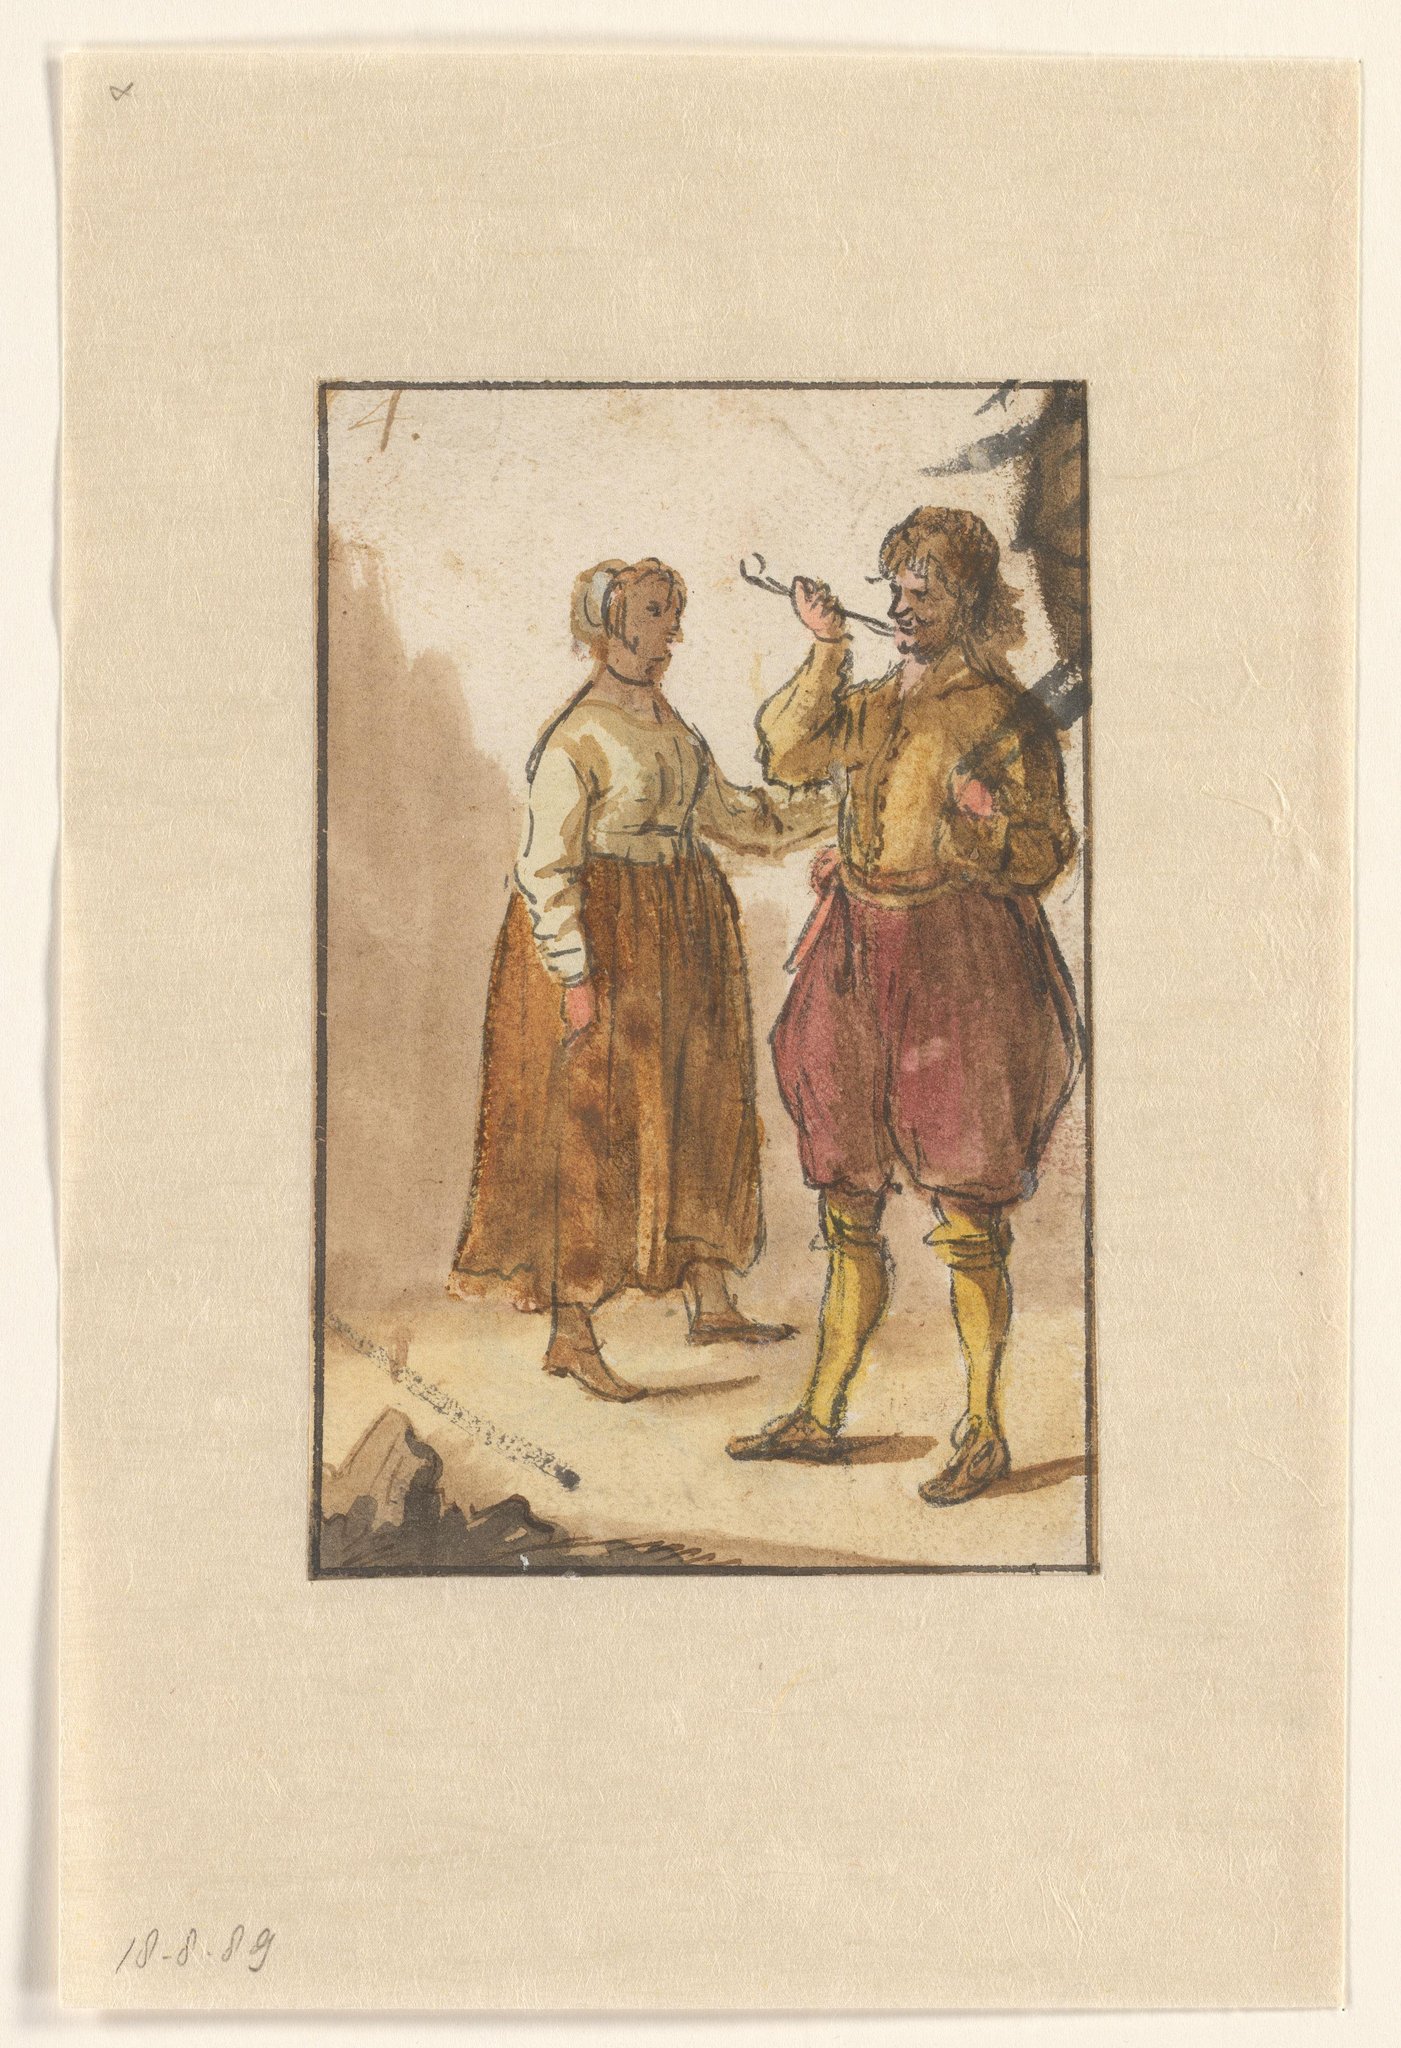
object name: drawing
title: Vier seizoenen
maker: Anonymous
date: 1600-1699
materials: paper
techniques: brush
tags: winter ~ human activities (the four seasons of the year), pipe ~ tobacco (+ taking (particular) foodstuffs: eating, drinking, smoking, chewing, etc.)